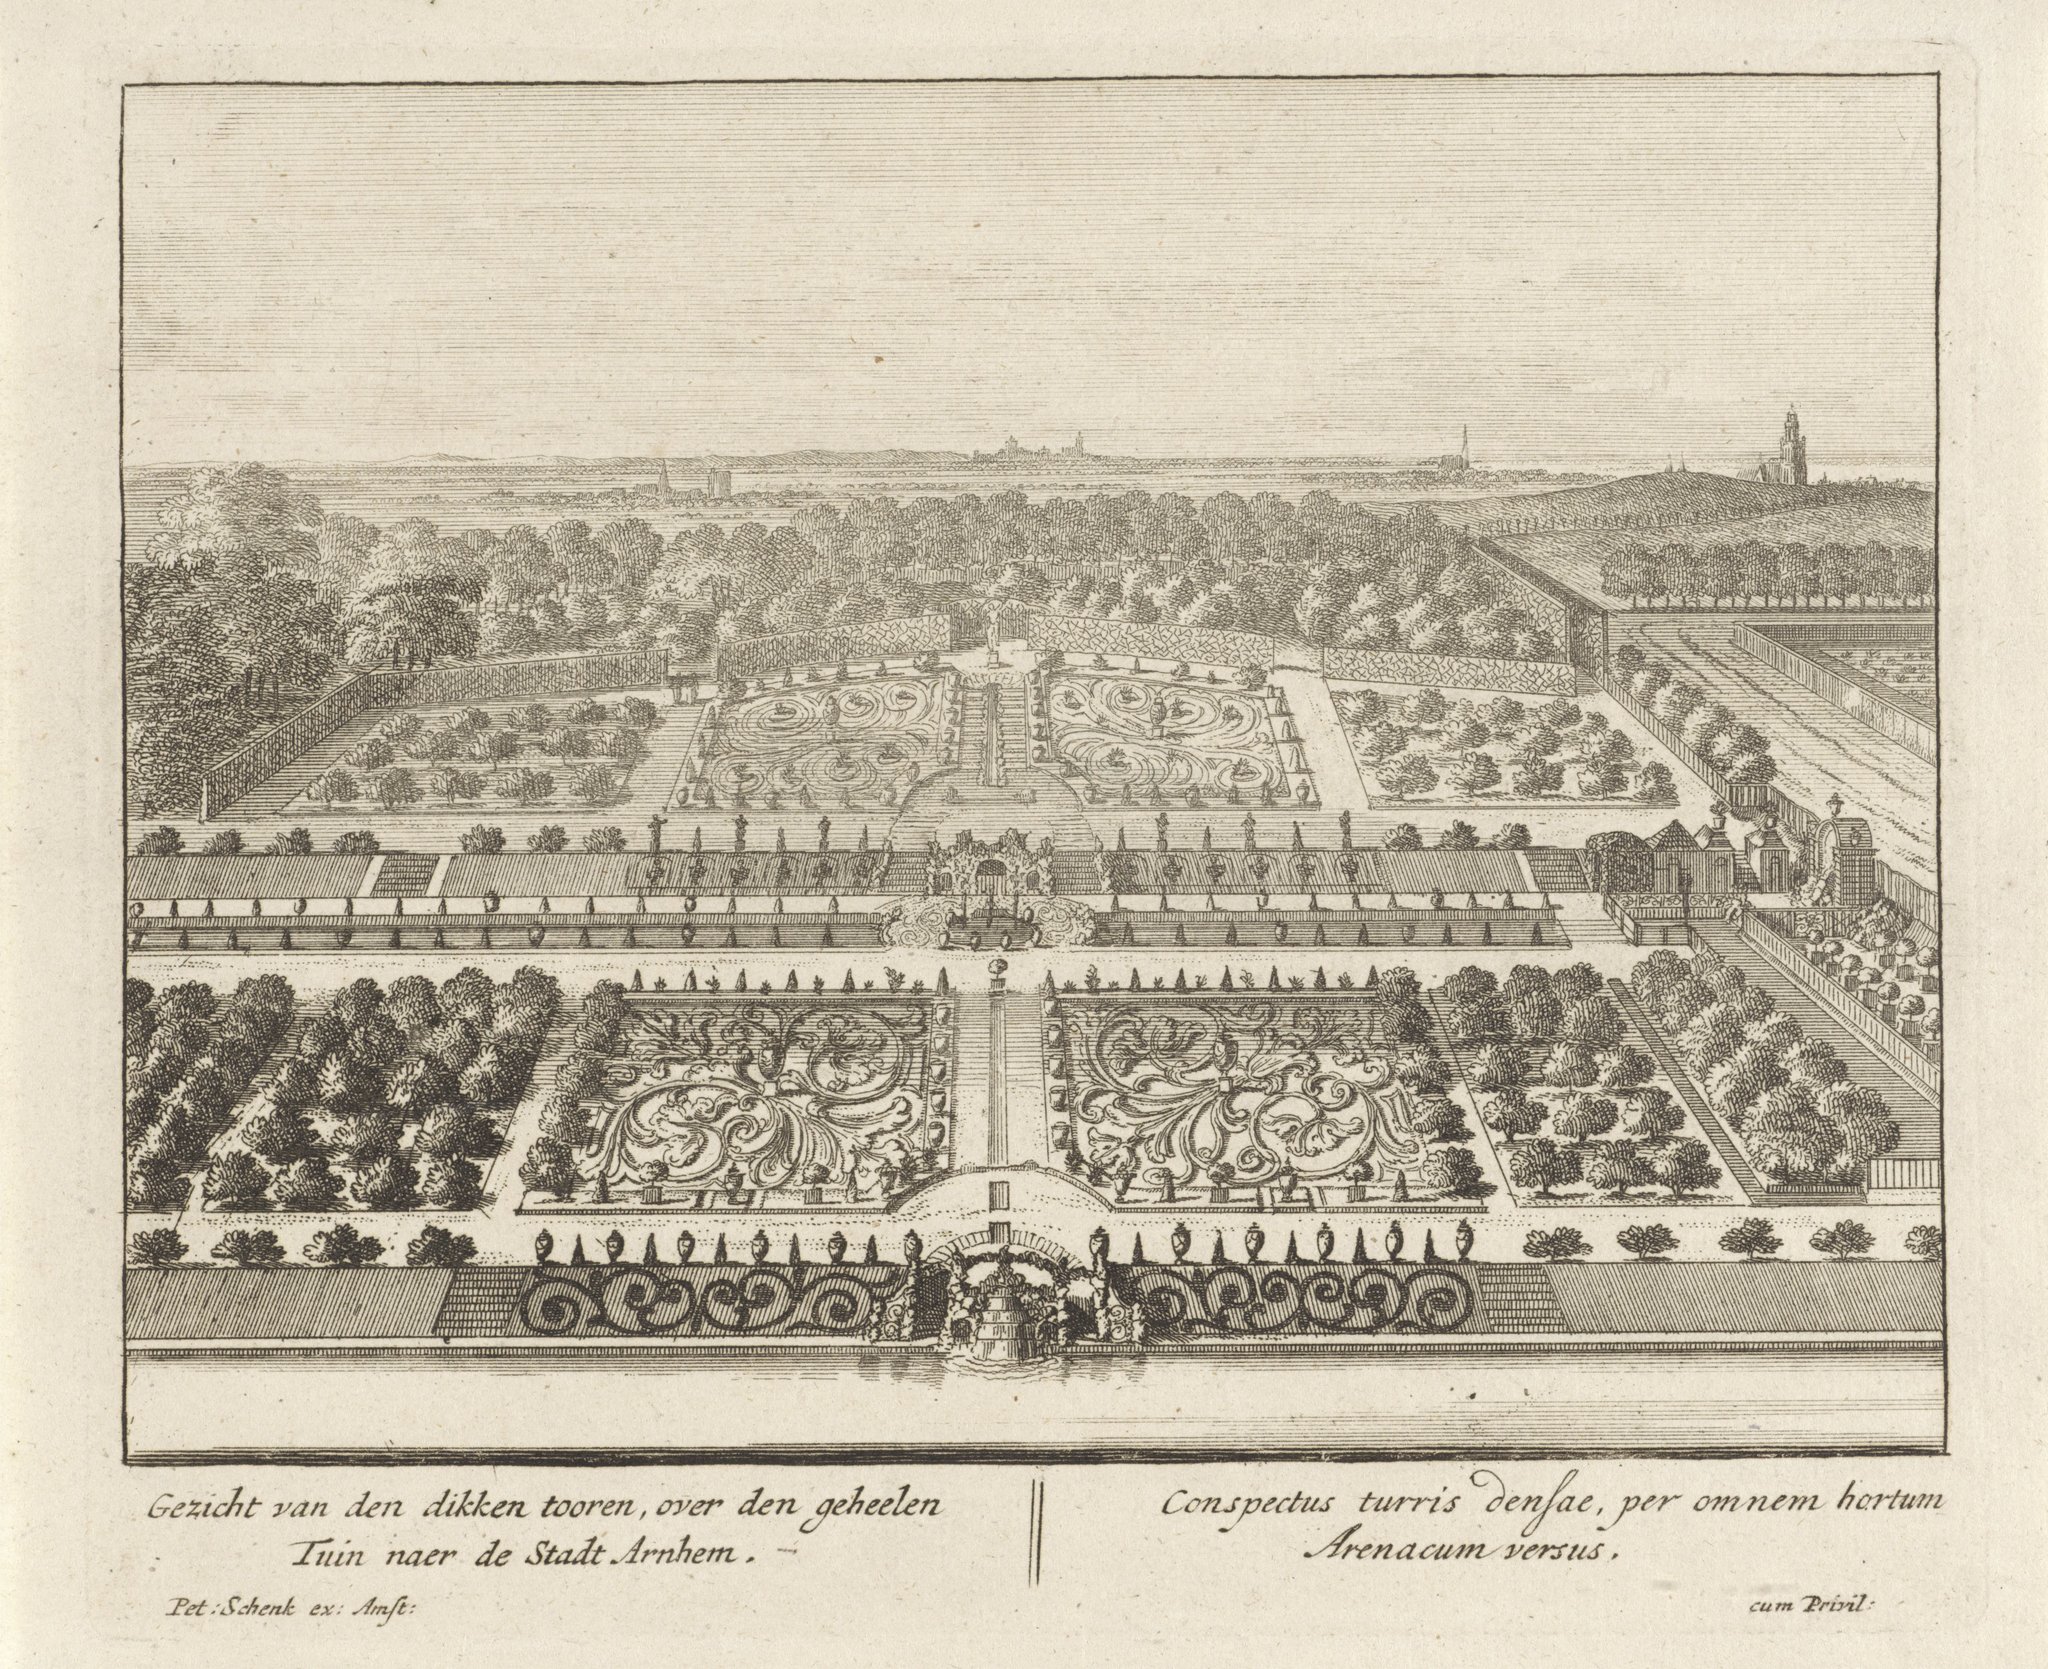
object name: print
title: Gezichten op Kasteel Rosendael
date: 1675-1711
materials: paper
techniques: etching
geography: amsterdam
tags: french or architectonic garden; formal garden, arnhem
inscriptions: collector's mark: Lugt 2228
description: Gezicht vanuit vogelperspectief op een deel van de tuin van Kasteel Rosendael. Op de achtergrond is de stad Arnhem te zien.